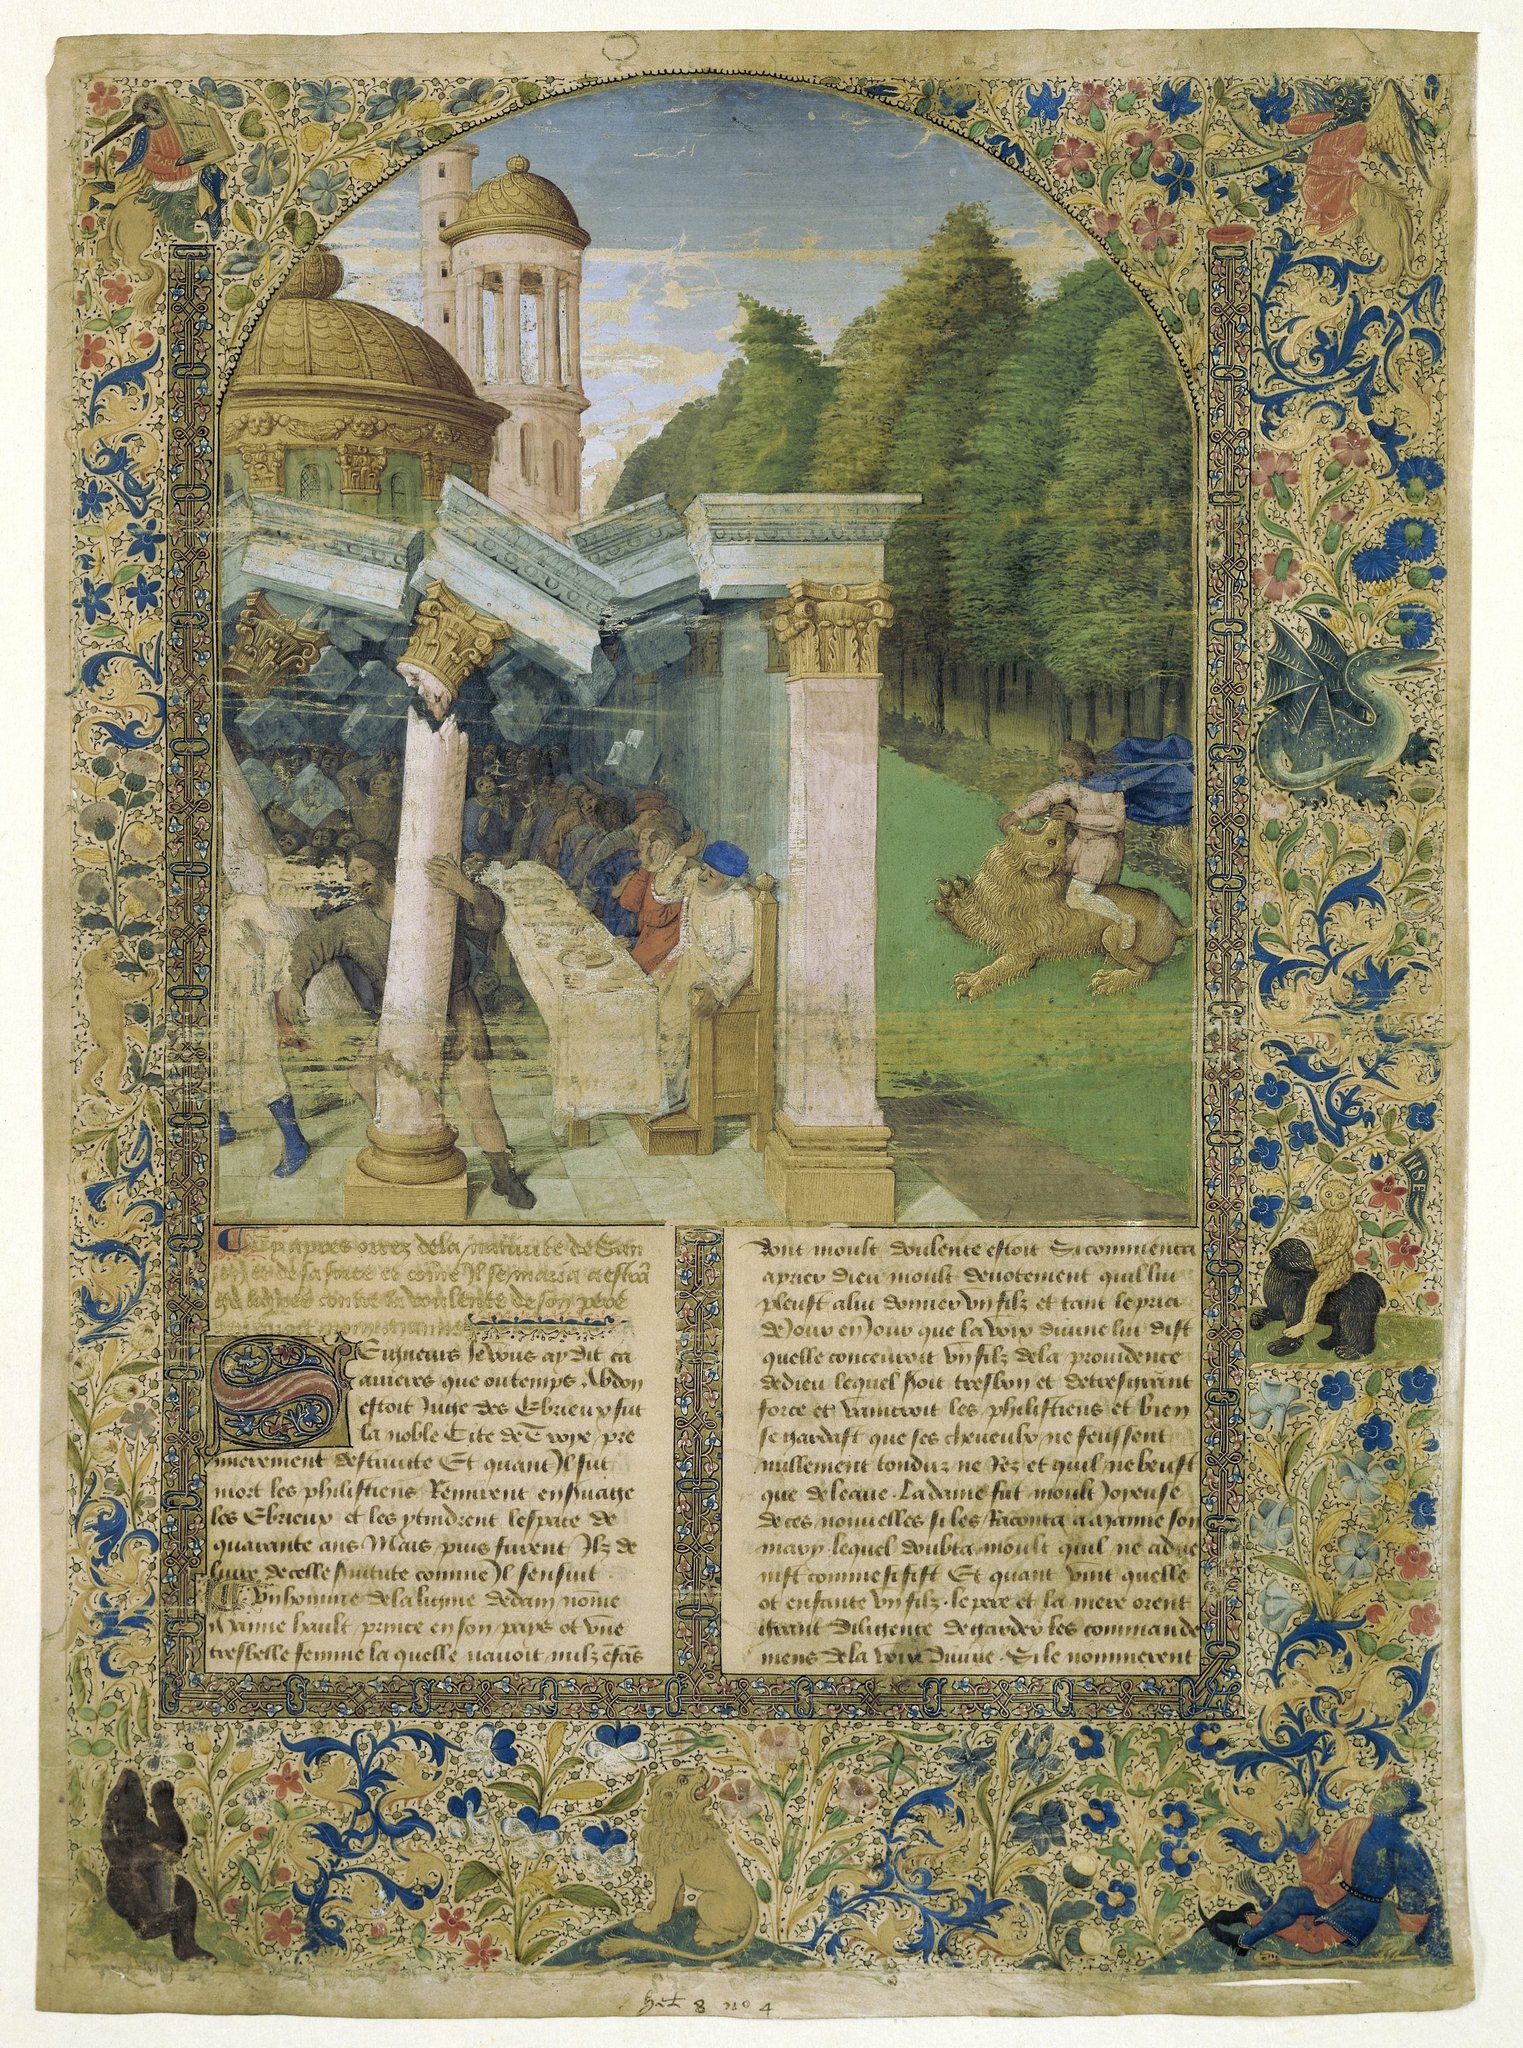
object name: drawing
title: Fragment van een Historiebijbel: twee scènes uit het leven van Samson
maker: Anonymous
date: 1470-1475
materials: paint, gold leaf, ink, parchment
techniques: brush, pen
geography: tours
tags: court jester, court fool, samson kills the lion with his bare hands, fabulous animals (sometimes wrongly called 'grotesques'); 'mostri' (ripa), samson breaks the pillars; the temple of dagon collapses, killing all that are in it, beasts of prey, predatory animals: bear, beasts of prey, predatory animals: lion, foliage, tendrils, branches ~ ornament, flowers ~ ornament